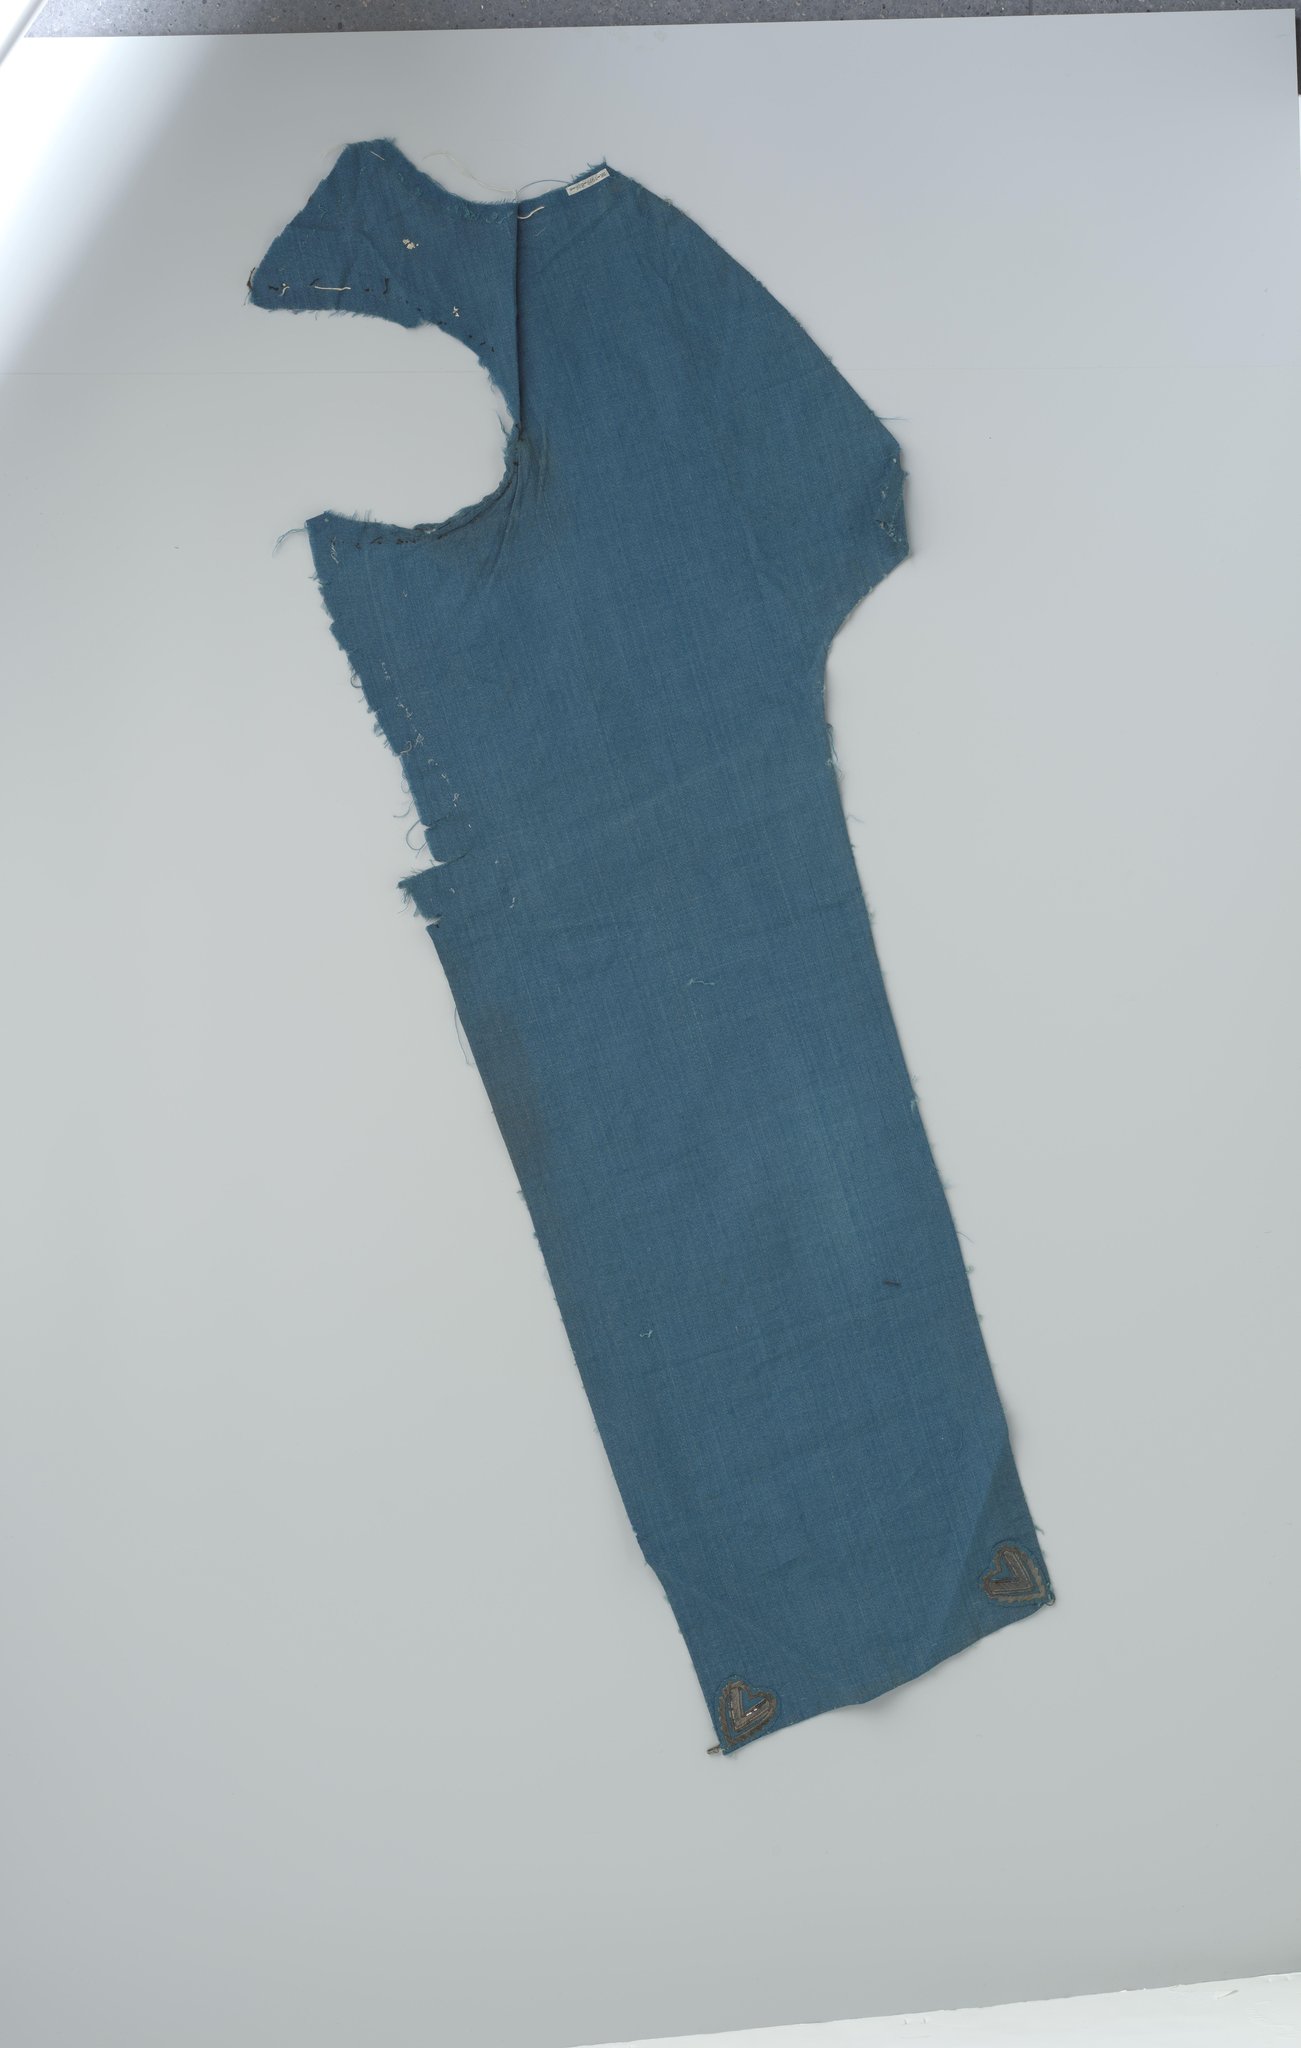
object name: uniform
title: Pand van blauw weefsel met twee hartvormige applicaties in zilverdraad met lovers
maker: Anonymous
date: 1800-1825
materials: thread, textile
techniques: appliqué, embroidered, sewing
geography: netherlands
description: Uniformfragmenten bestaande uit: twee kragen, manchetomslagen, paar revers met één en zeven paar lissen, voering en rug- en voorpanden; voor livrei of schutterij (?). Deze uniformfragmenten waren op het moment van invoer nog niet beschikbaar en daar de aantallen e.d. onduidelijk zijn, is bij deze invoer alleen volstaan met de vermelding van de diverse onderdelen. De invoer per onderdeel moet dus nog volgen.